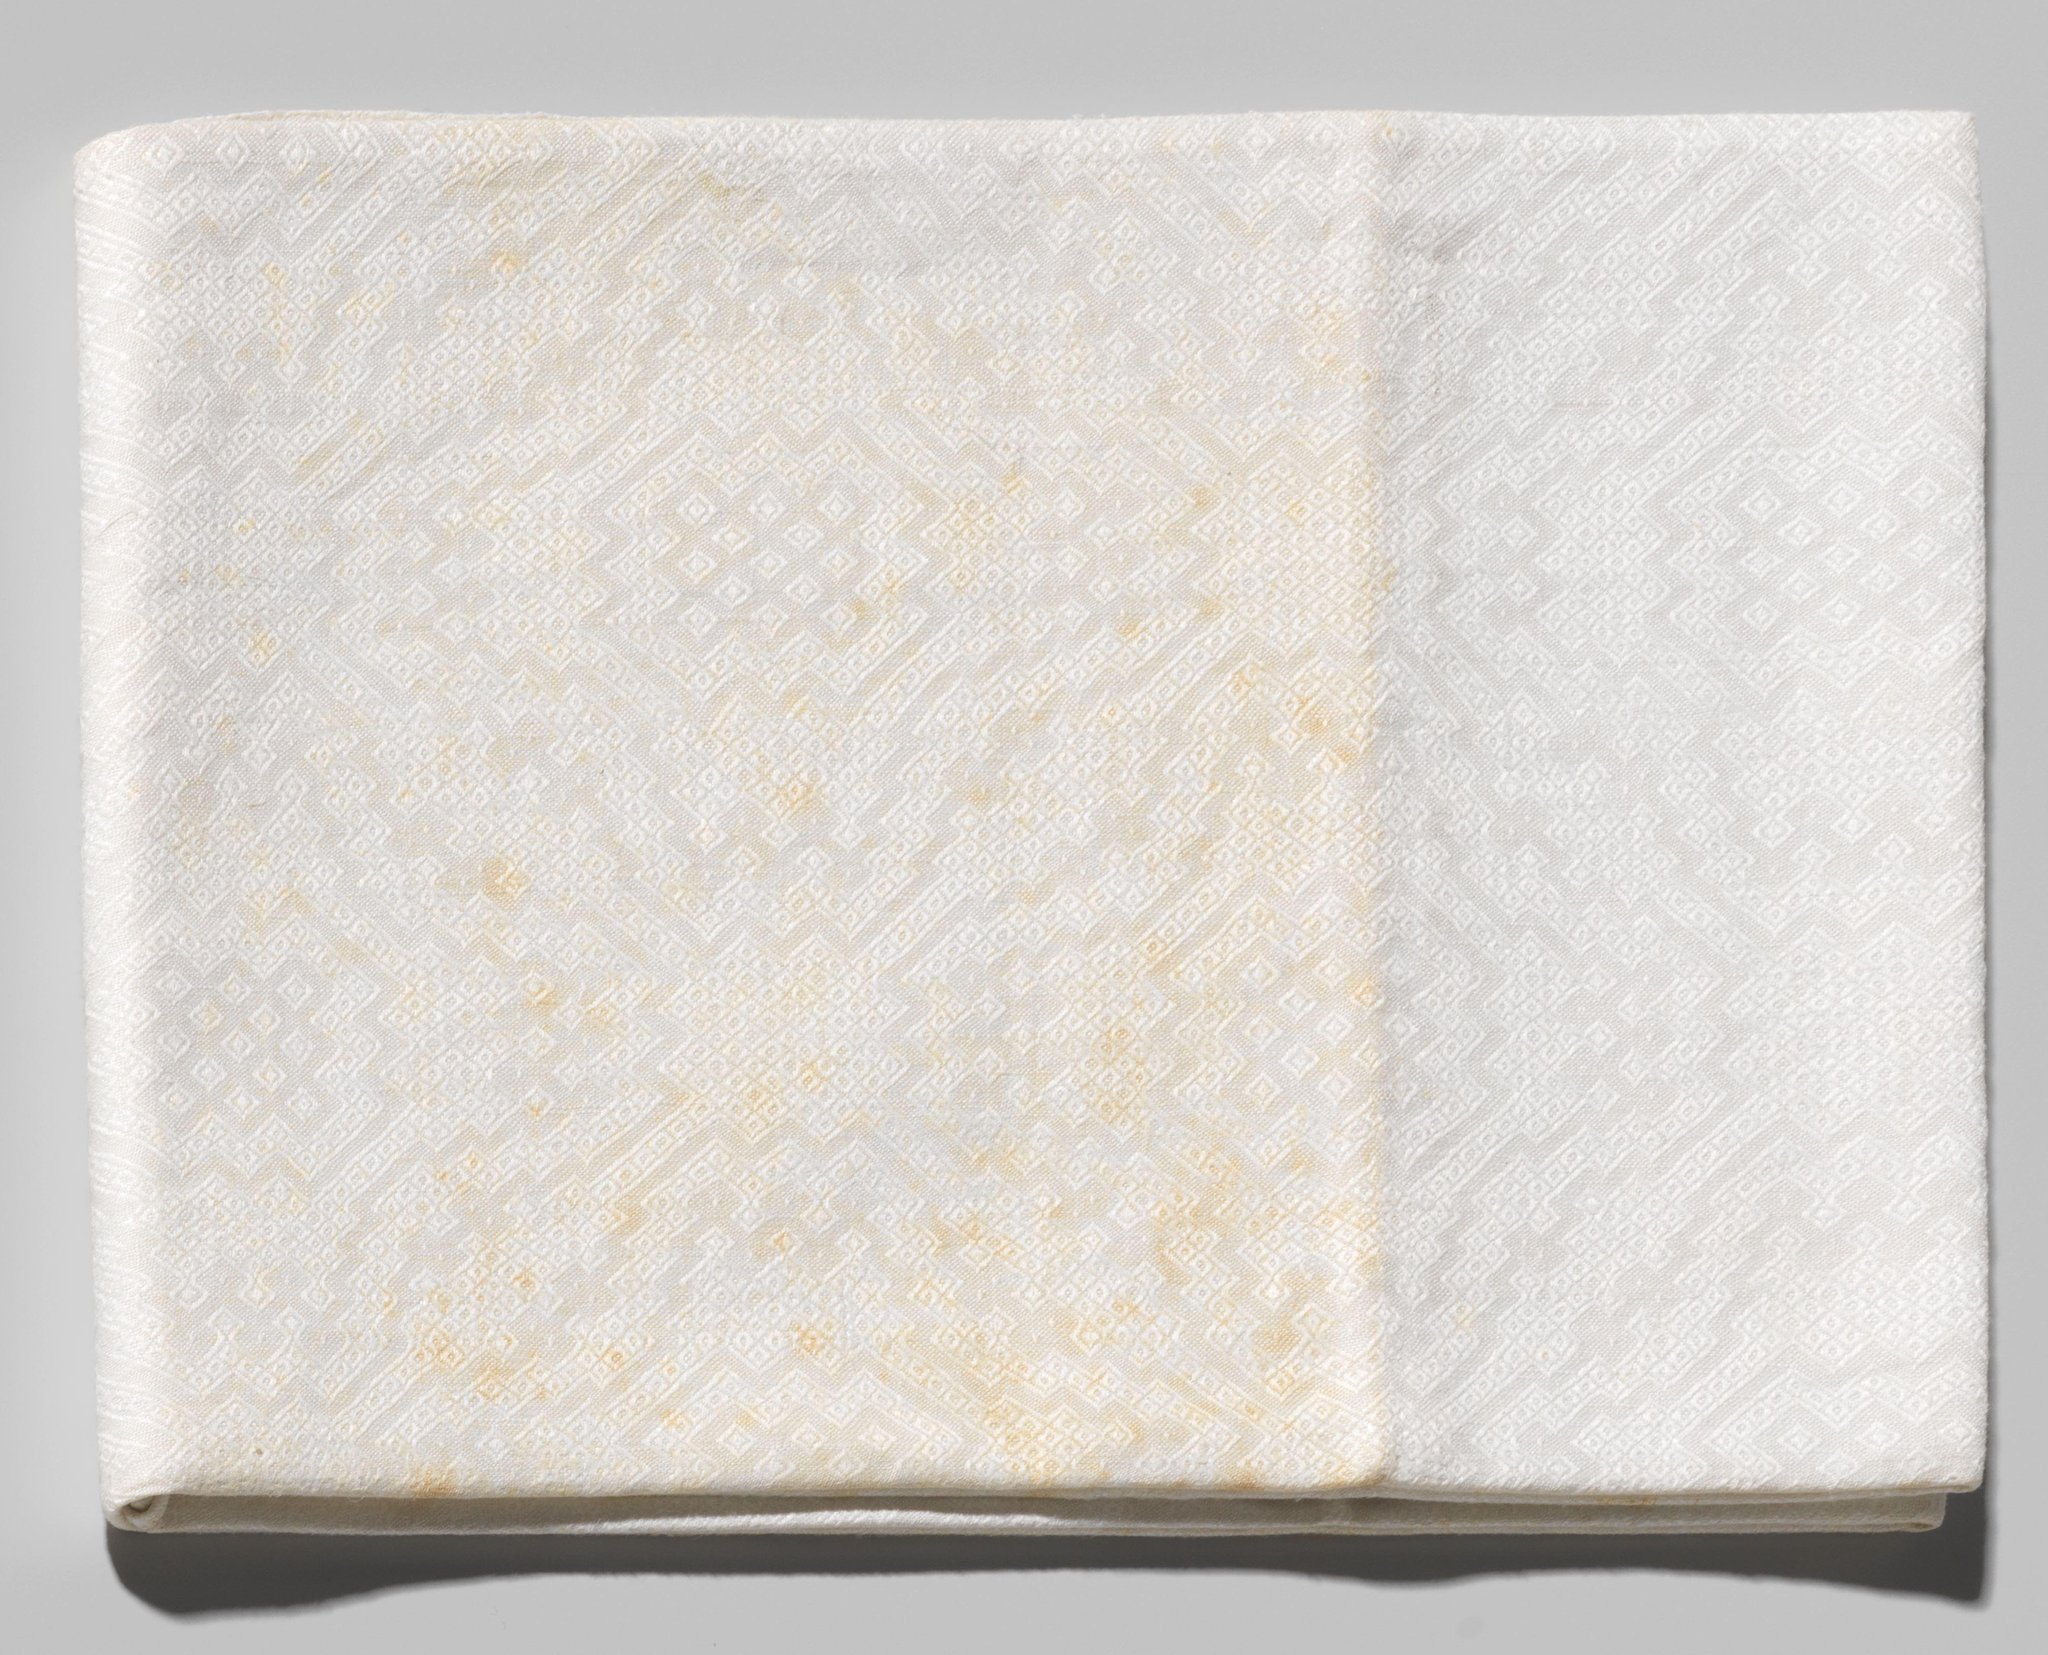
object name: napkin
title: Servet met patroon van kruiswerk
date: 1675-1700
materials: linen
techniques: peeled fabric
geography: haarlem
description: Servet van wit linnendamast met een patroon van een oneindig rapport van netwerk met geblokt kruis op het snijpunt, met verdikkingen op de zijden en met vulling van trapsgewijs gecontoureerde concentrische veelhoeken, eveneens geblokt. Twee open zomen. Gemerkt met gaatjesmerk M.P. en kleiner onleesbaar merkje.